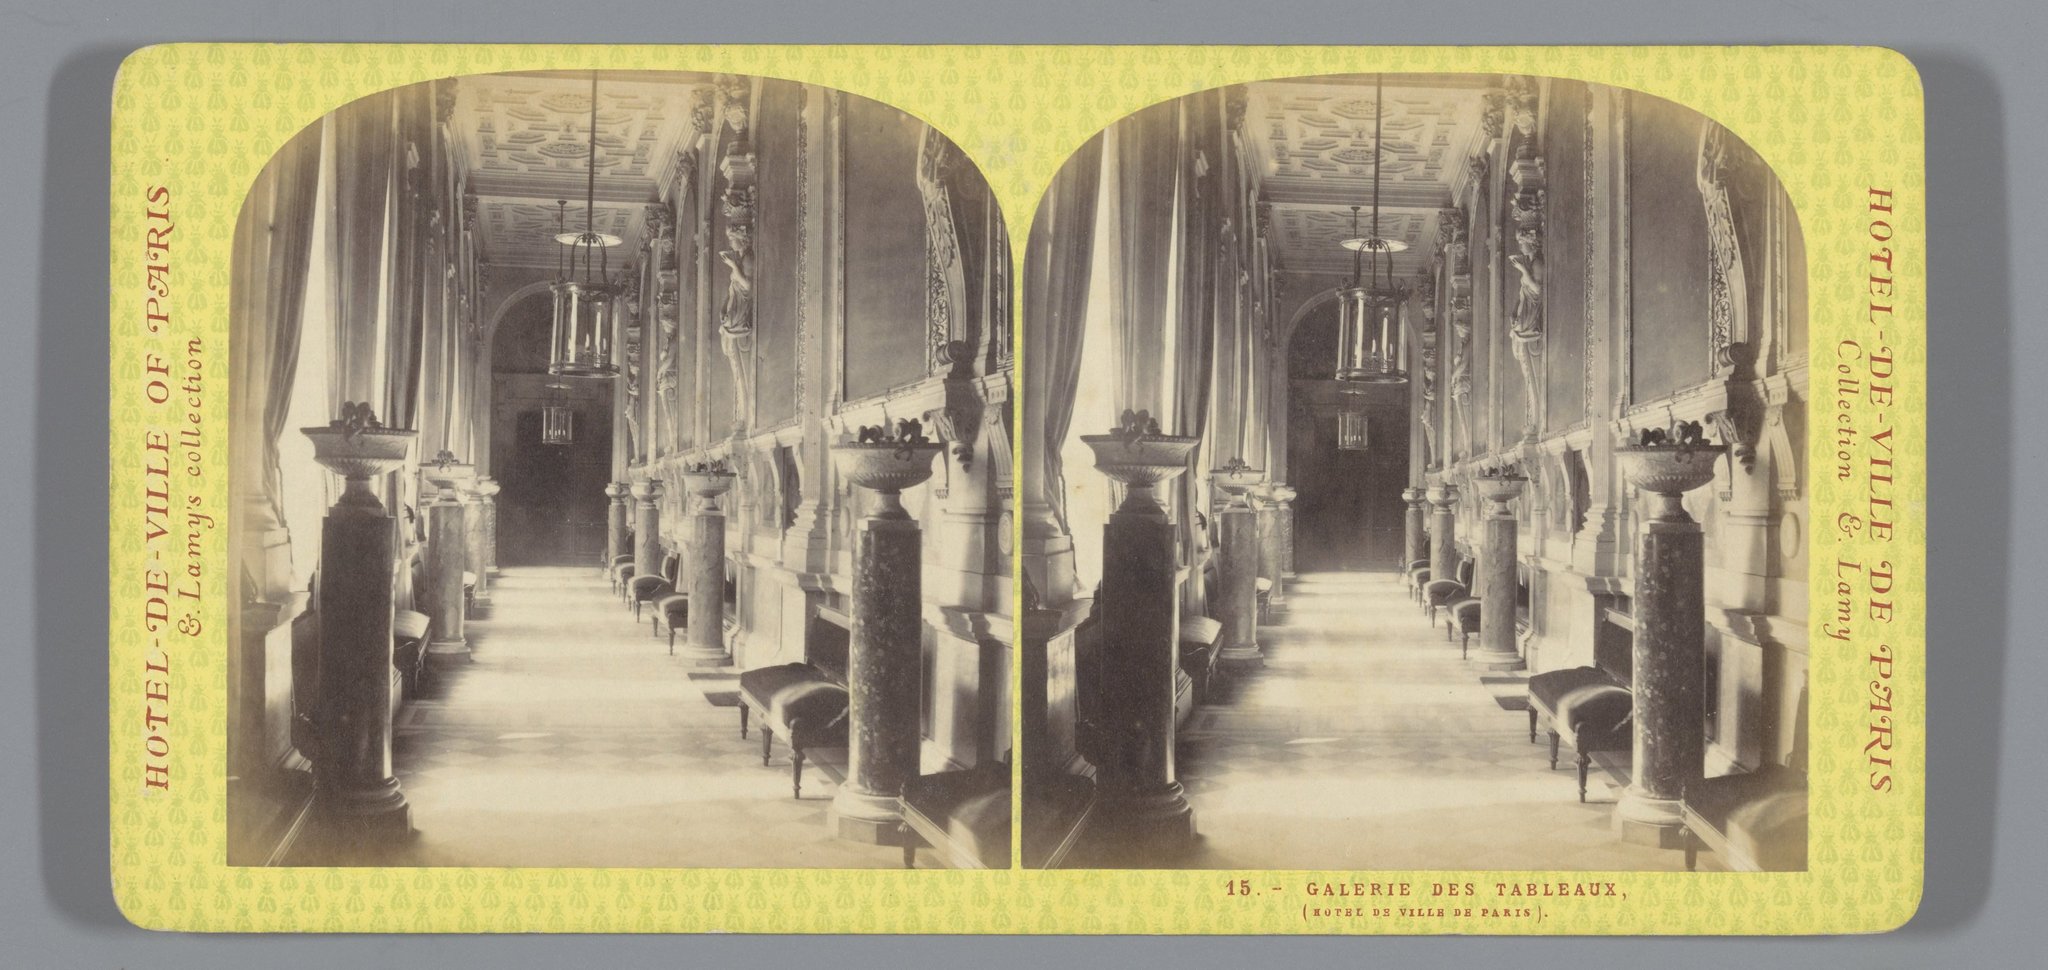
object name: stereograph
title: Galerie des Tableaux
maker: ernest eléonor pierre lamy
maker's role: publisher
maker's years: 1828-1900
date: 1860-1880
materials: cardboard, photographic support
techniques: albumen print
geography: paris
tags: townhall, interior ~ representation of a building, 'gemalte galerie'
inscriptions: inscription: ‘E. Lamy's collection’, inscription: ‘15.’